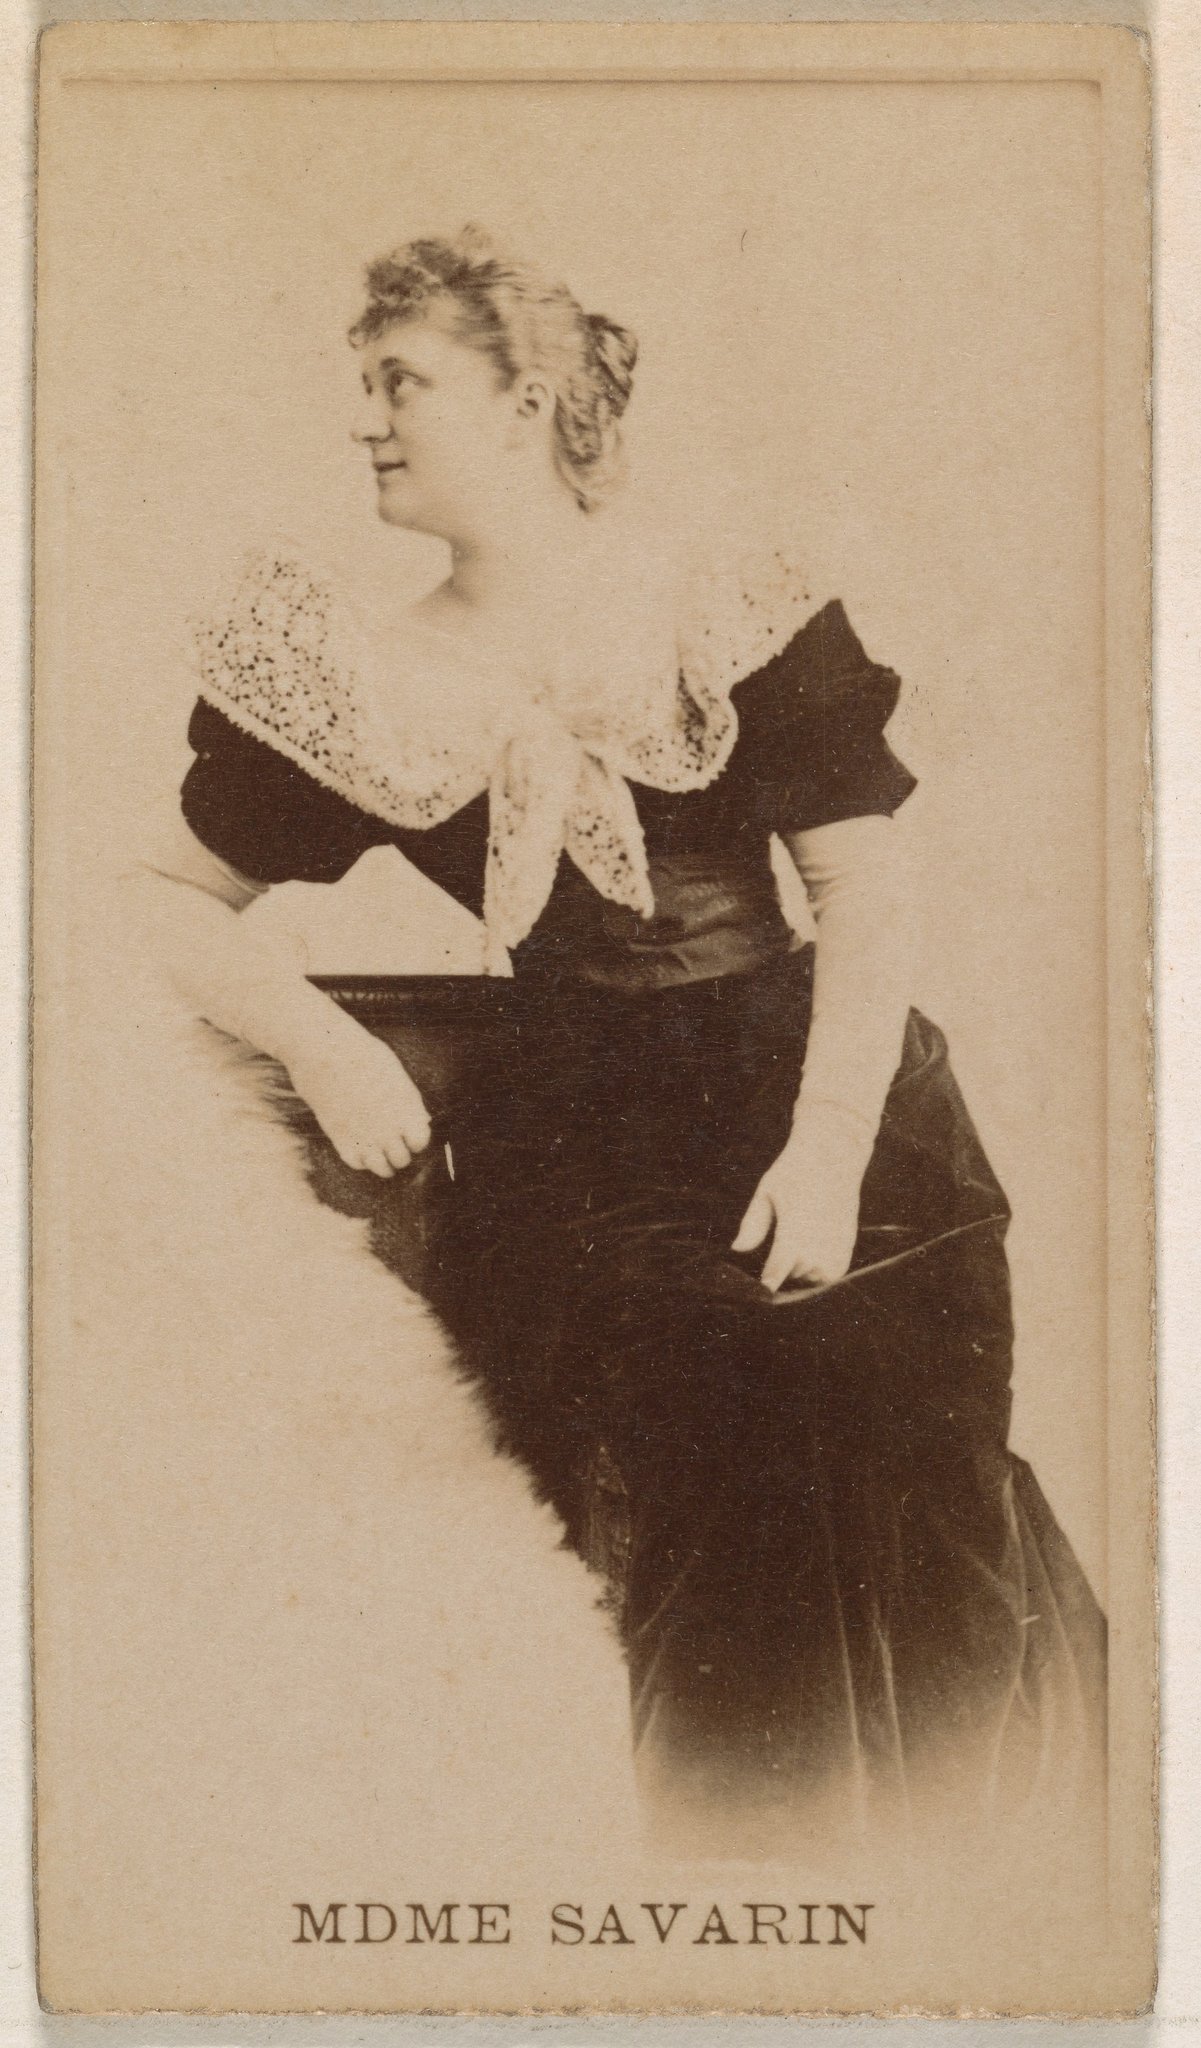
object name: photograph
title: Mdme. Savarin, from the Actresses series (N245) issued by Kinney Brothers to promote Sweet Caporal Cigarettes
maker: kinney brothers tobacco company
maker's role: publisher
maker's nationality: american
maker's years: 1869-2011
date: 1890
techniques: albumen silver print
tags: women,actresses